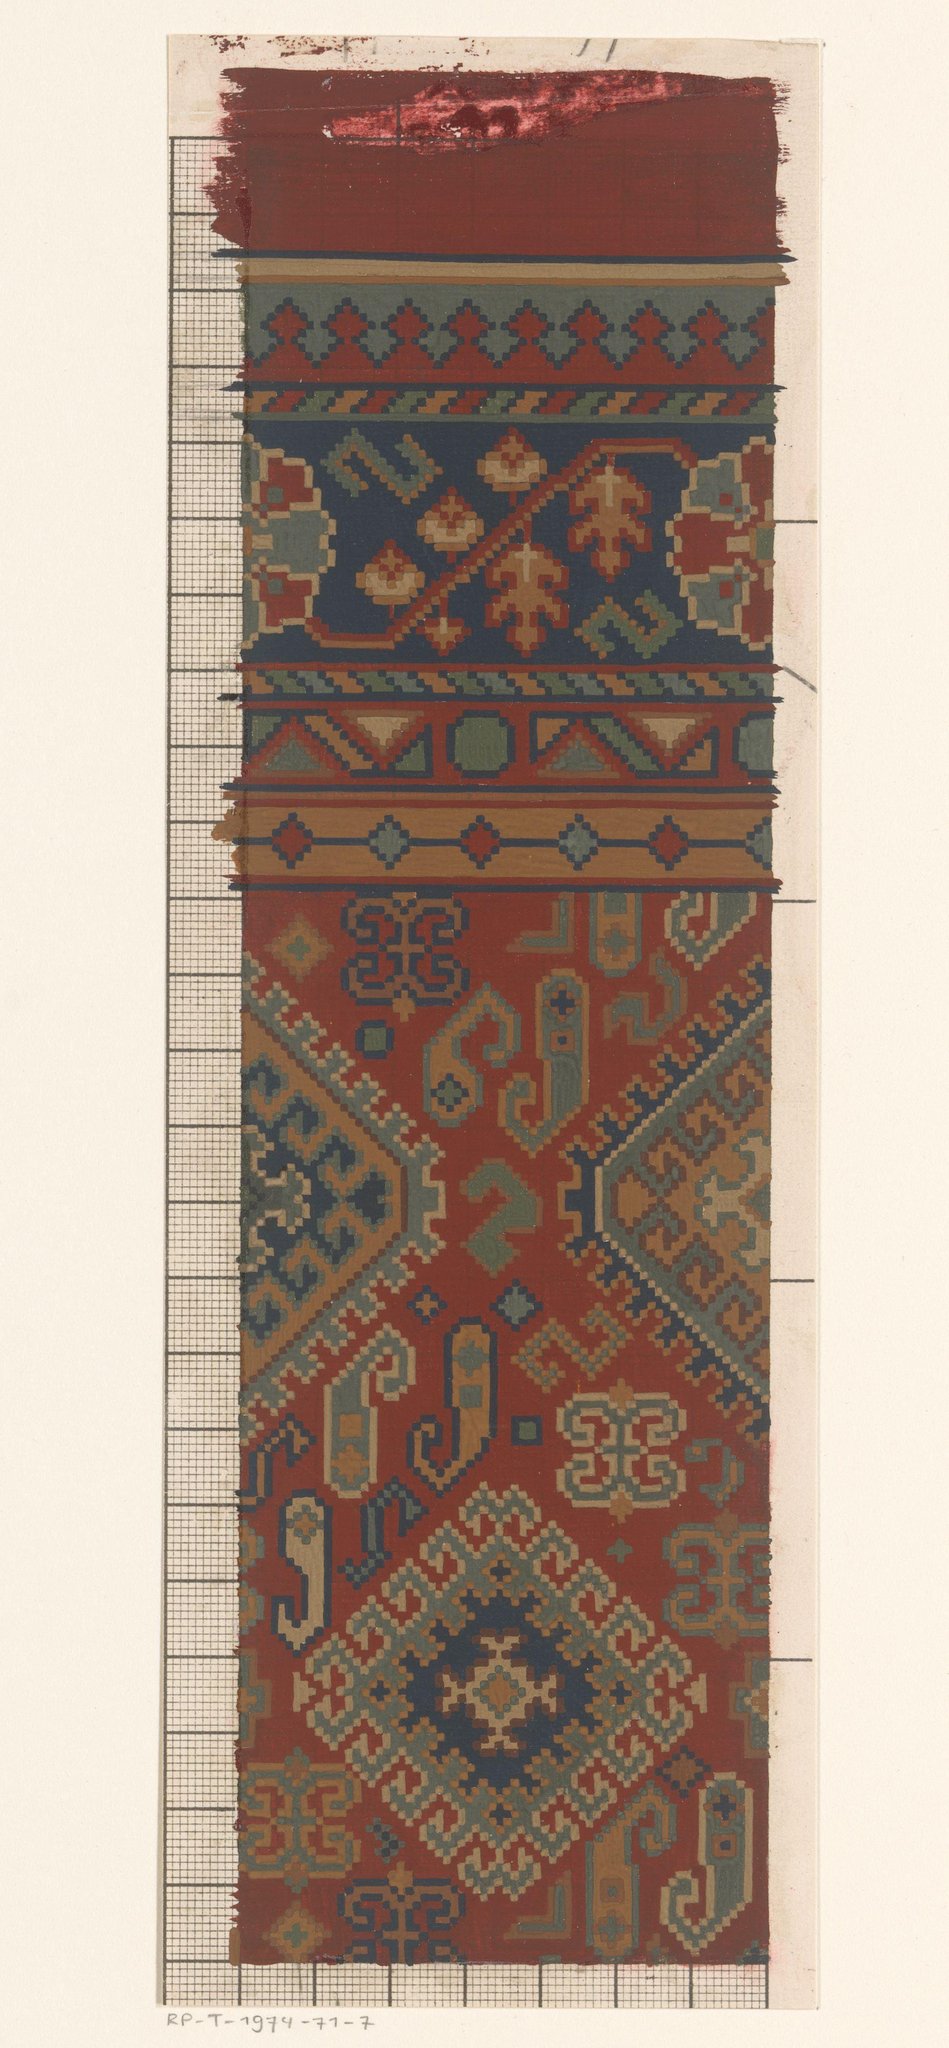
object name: design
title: Ontwerp voor een tapijt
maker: Anonymous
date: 1922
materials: paint, paper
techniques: brush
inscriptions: collector's mark: ‘R:MVS’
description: Bij het object in een kaartje van de Koninklijke Vereenigde Tapijtfabrieken te Rotterdam, Deventer en 's-Gravenhage opgezet.